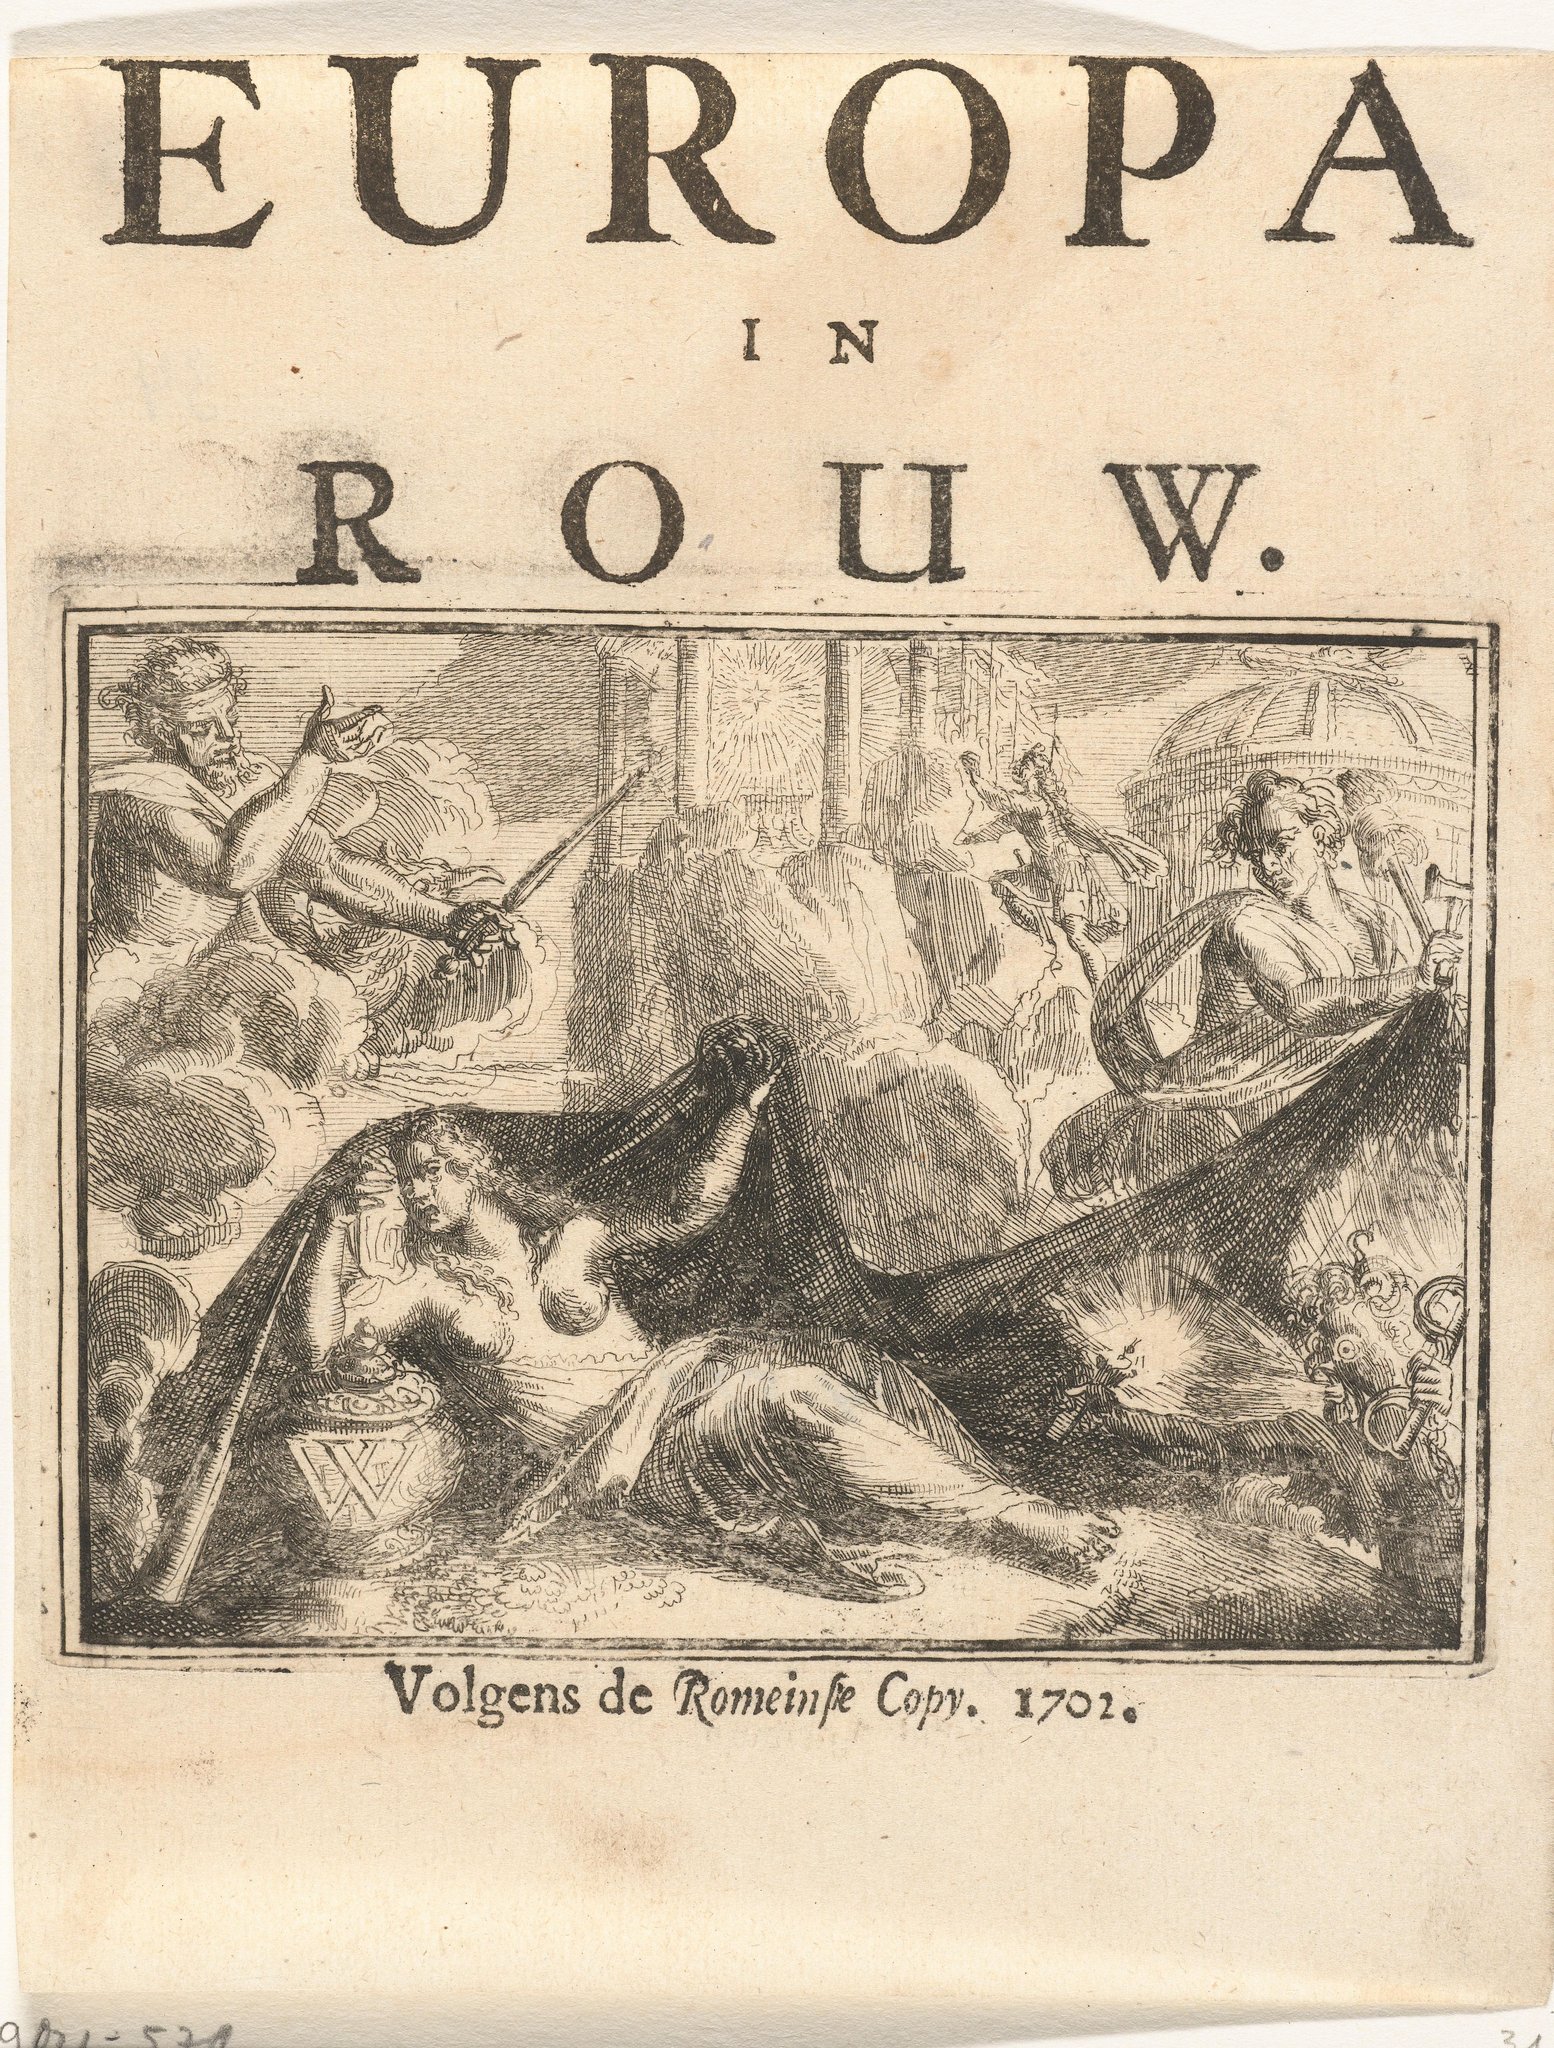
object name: print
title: Esopus in Europa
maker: romeyn de hooghe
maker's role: draughtsman, goldsmith, painter, print maker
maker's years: 1645-1708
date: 1702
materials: paper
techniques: etching, letterpress printing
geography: northern netherlands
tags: the hague, william iii (prince of orange and king of england, scotland, and ireland), europe represented allegorically; 'europa' (ripa), apotheosis of a ruler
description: Titelblad voor het pamflet: Europa in Rouw, 1702. Europa rouwt onder een groot laken om de dood van koning Willem III, op 19 maart 1702, die op de achtergrond naar de hemel opstijgt.